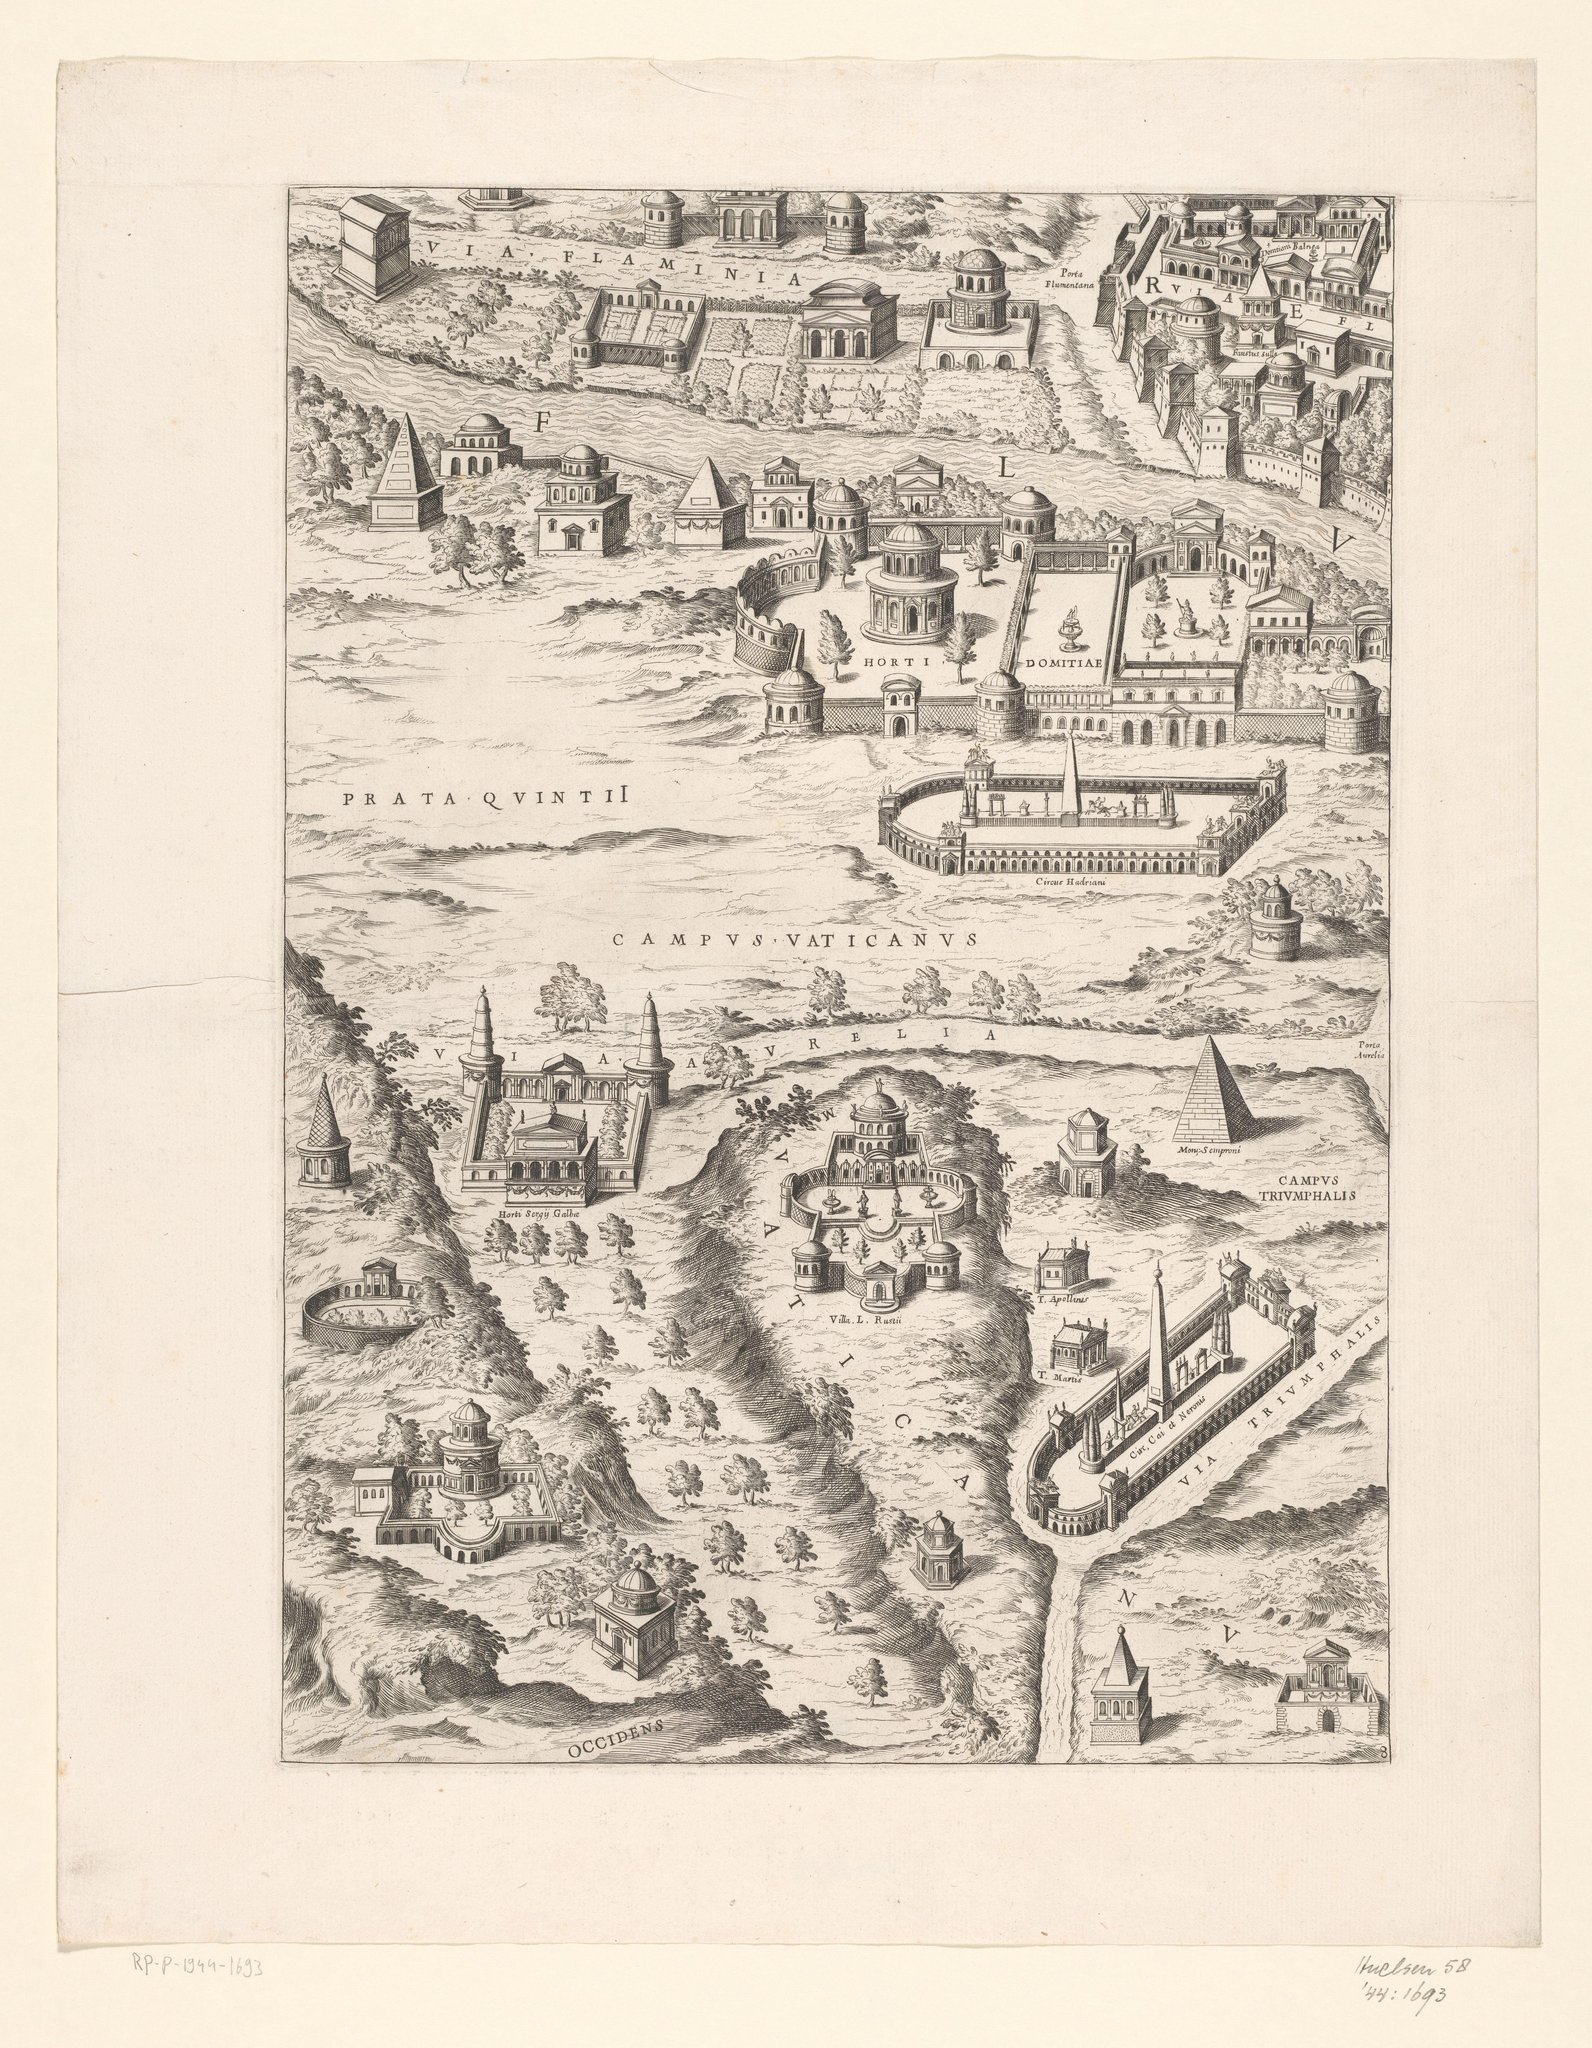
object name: area plan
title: Urbis Romae sciographia ex antiquis monumentis accuratiss delineata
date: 1639-1691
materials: paper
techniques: engraving, etching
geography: rome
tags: maps of cities, rome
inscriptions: collector's mark: Lugt 2228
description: Vijfde deel van een plattegrond van Rome in vogelvluchtperspectief, bestaande uit acht delen. Rechtsonder genummerd: 5.